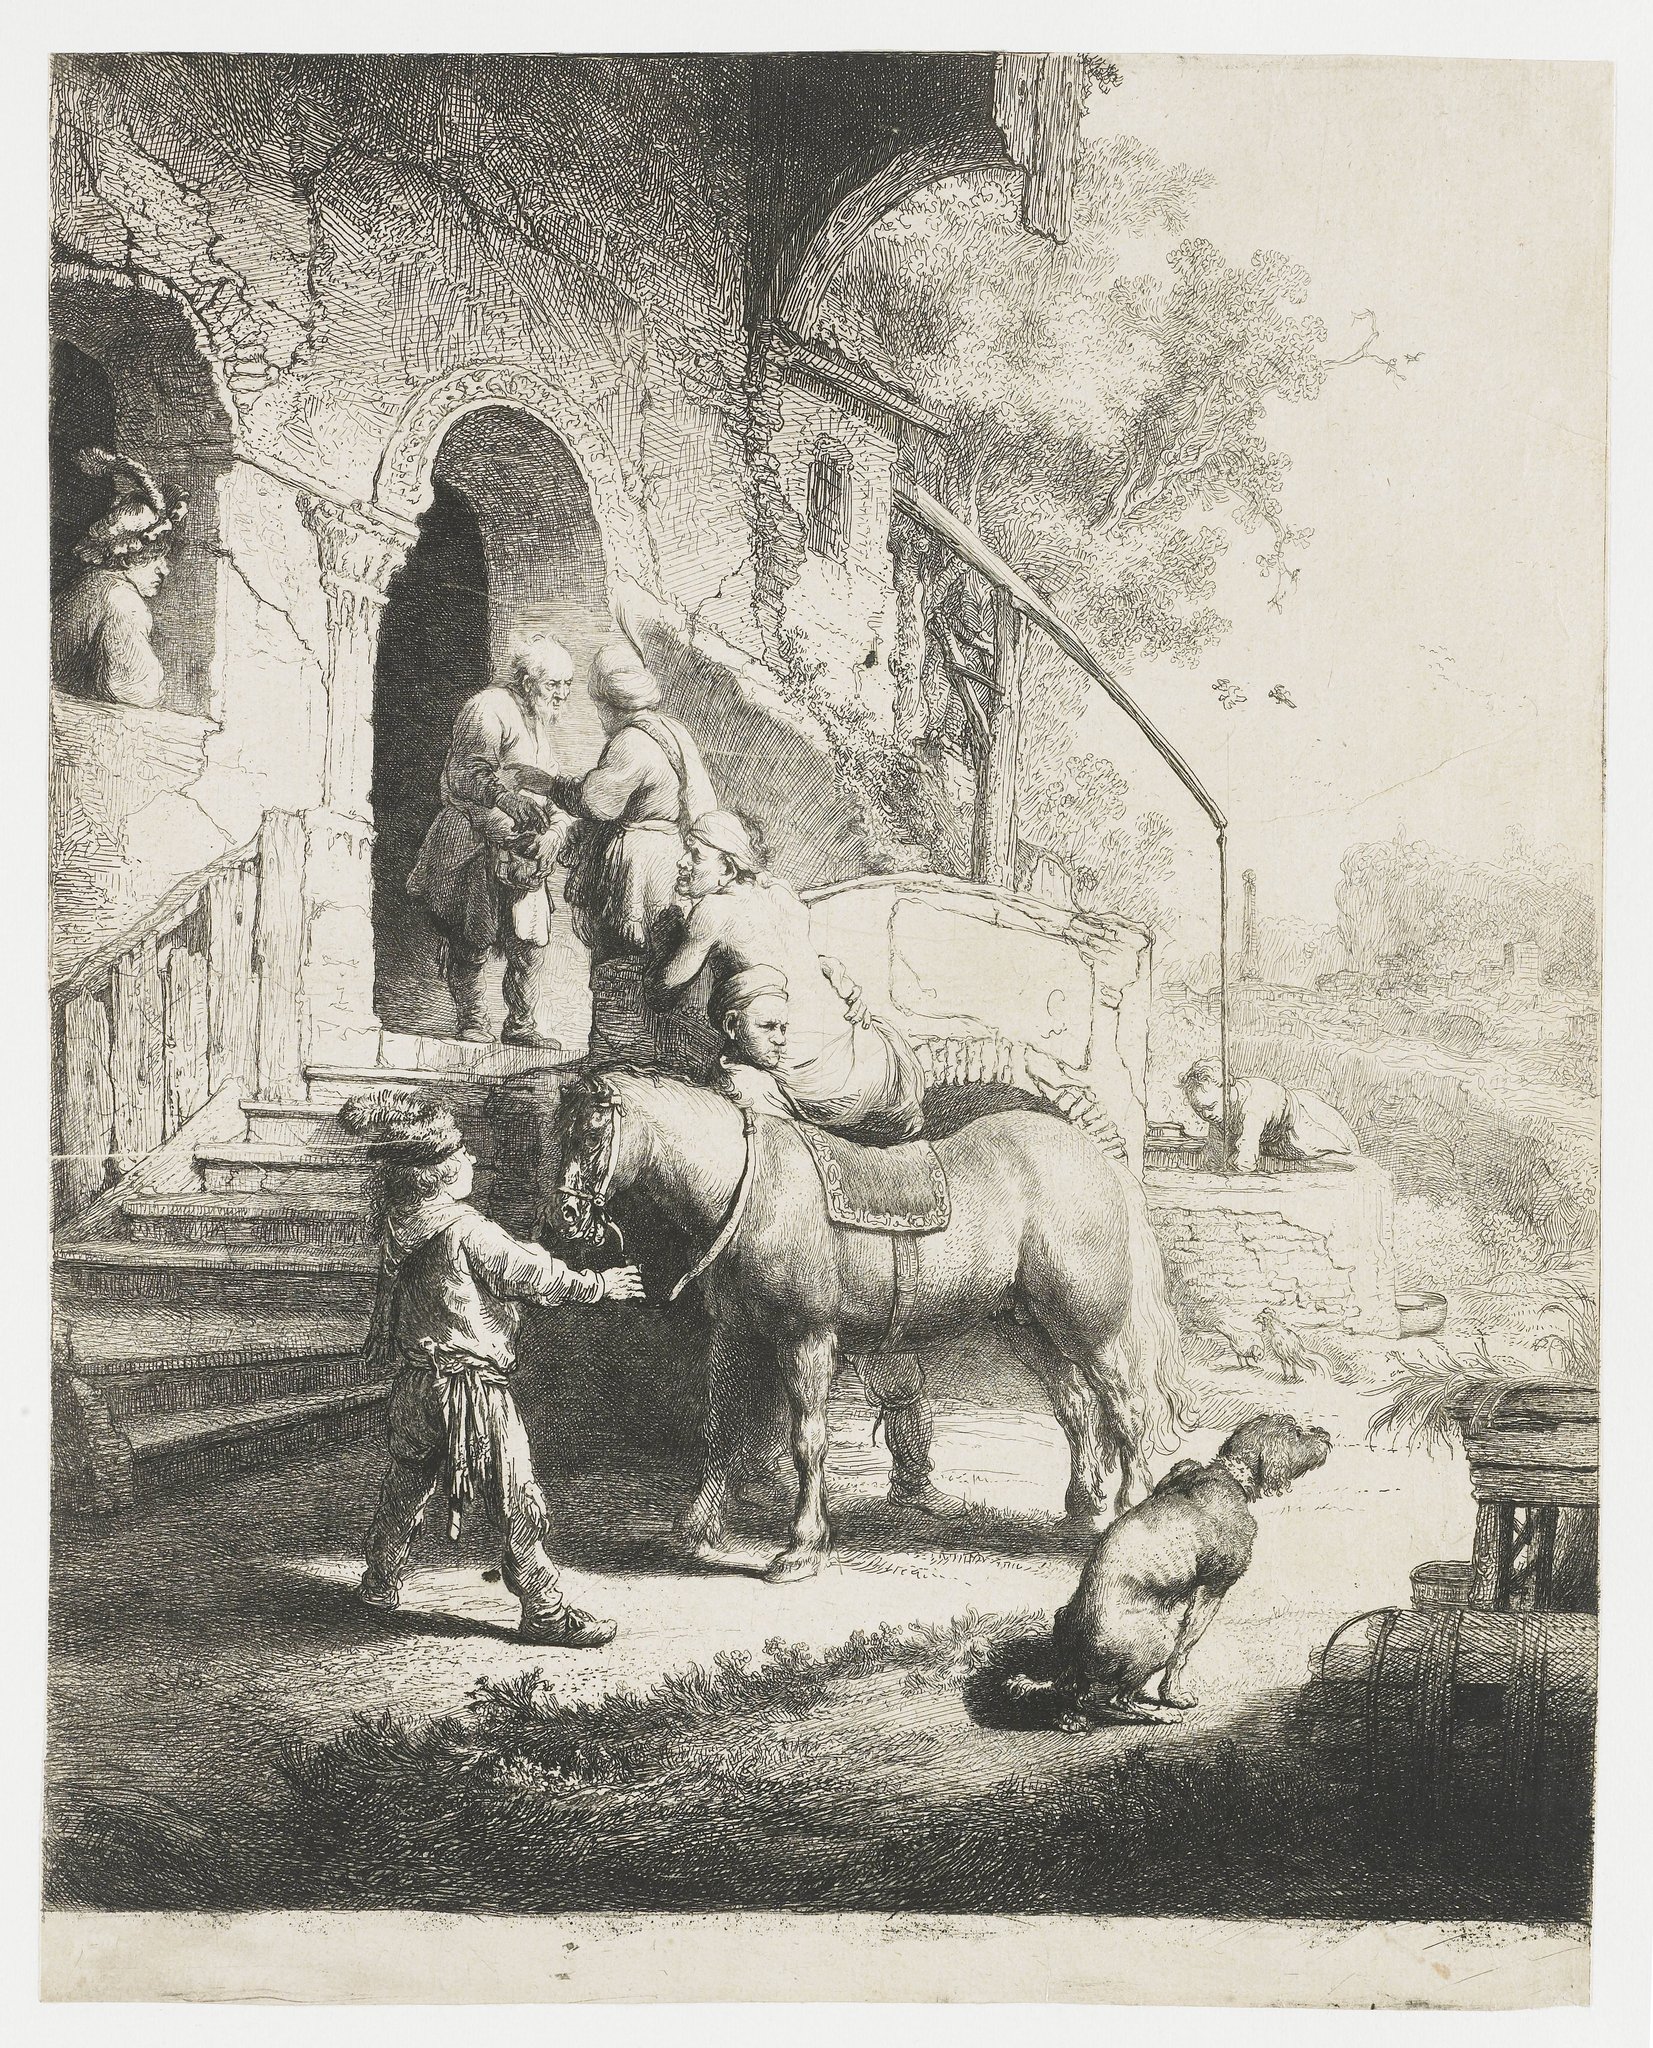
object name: print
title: The good Samaritan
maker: rembrandt van rijn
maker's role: draughtsman, painter, print maker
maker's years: 1606-1669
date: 1633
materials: paper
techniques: etching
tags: the good samaritan (luke 10:30-37)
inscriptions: collector's mark: Lugt 240